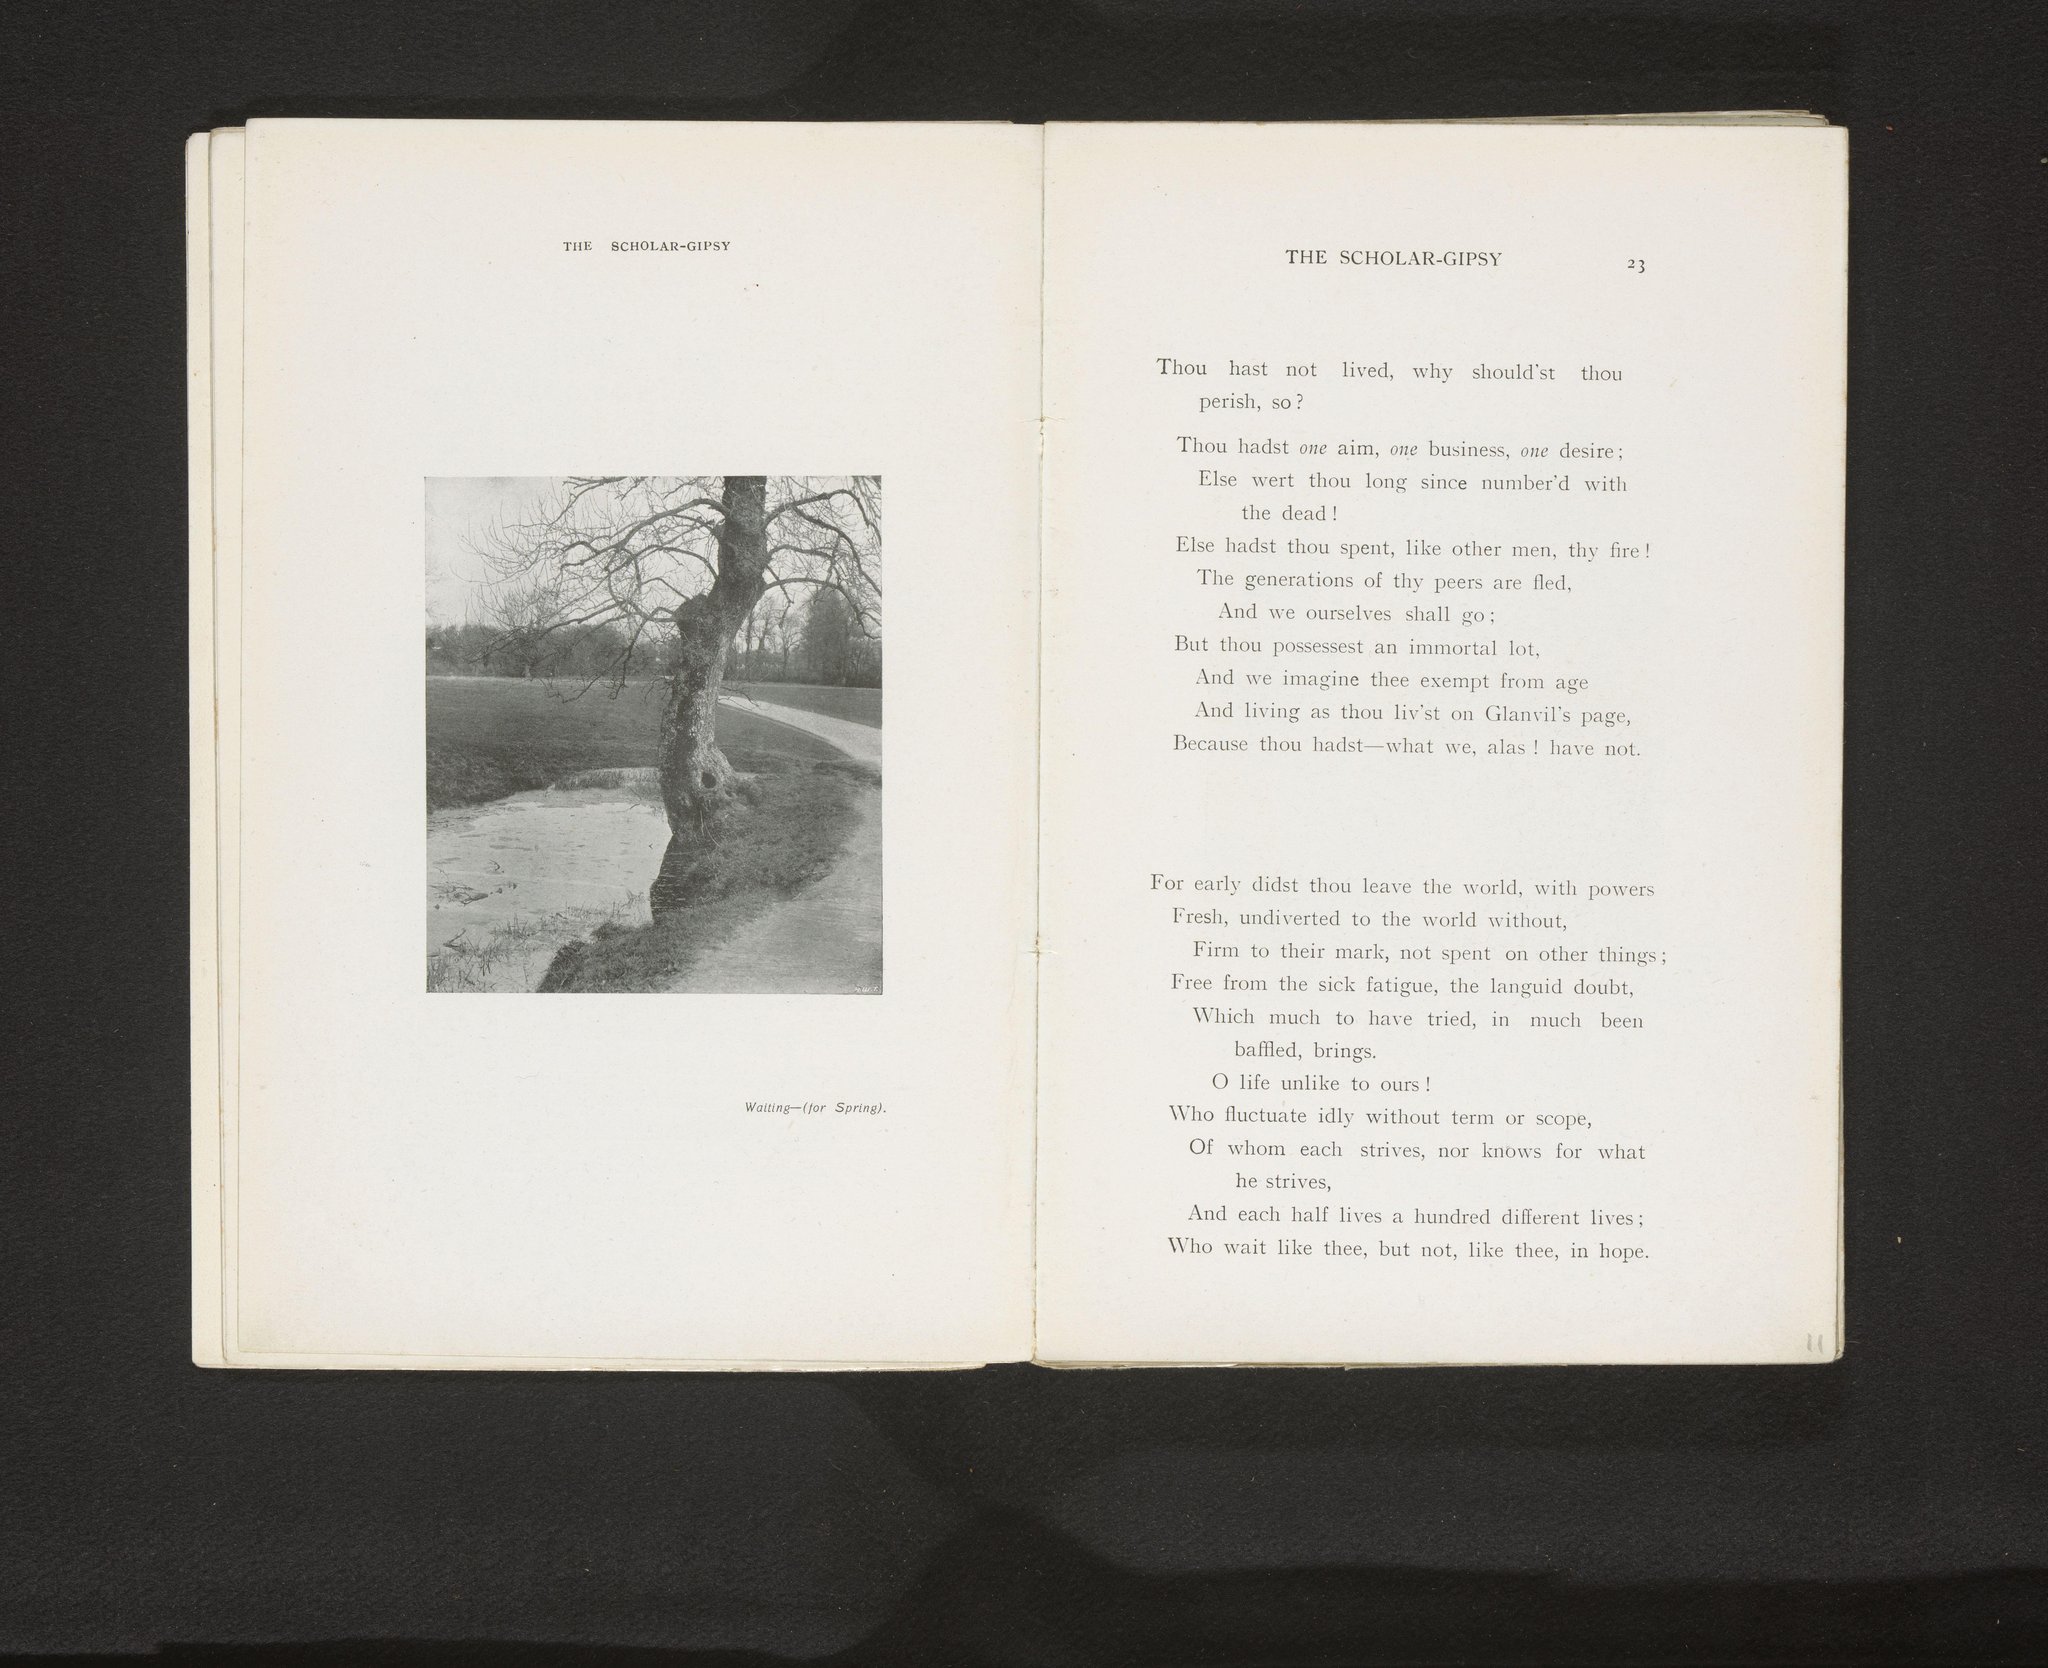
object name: photomechanical print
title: Boom langs een sloot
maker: henry w. taunt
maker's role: fotograaf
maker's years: 1842-1922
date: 1907-1912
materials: paper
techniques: autotype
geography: united kingdom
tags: trees, water course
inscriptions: inscription: ‘Waiting-(for Spring)’